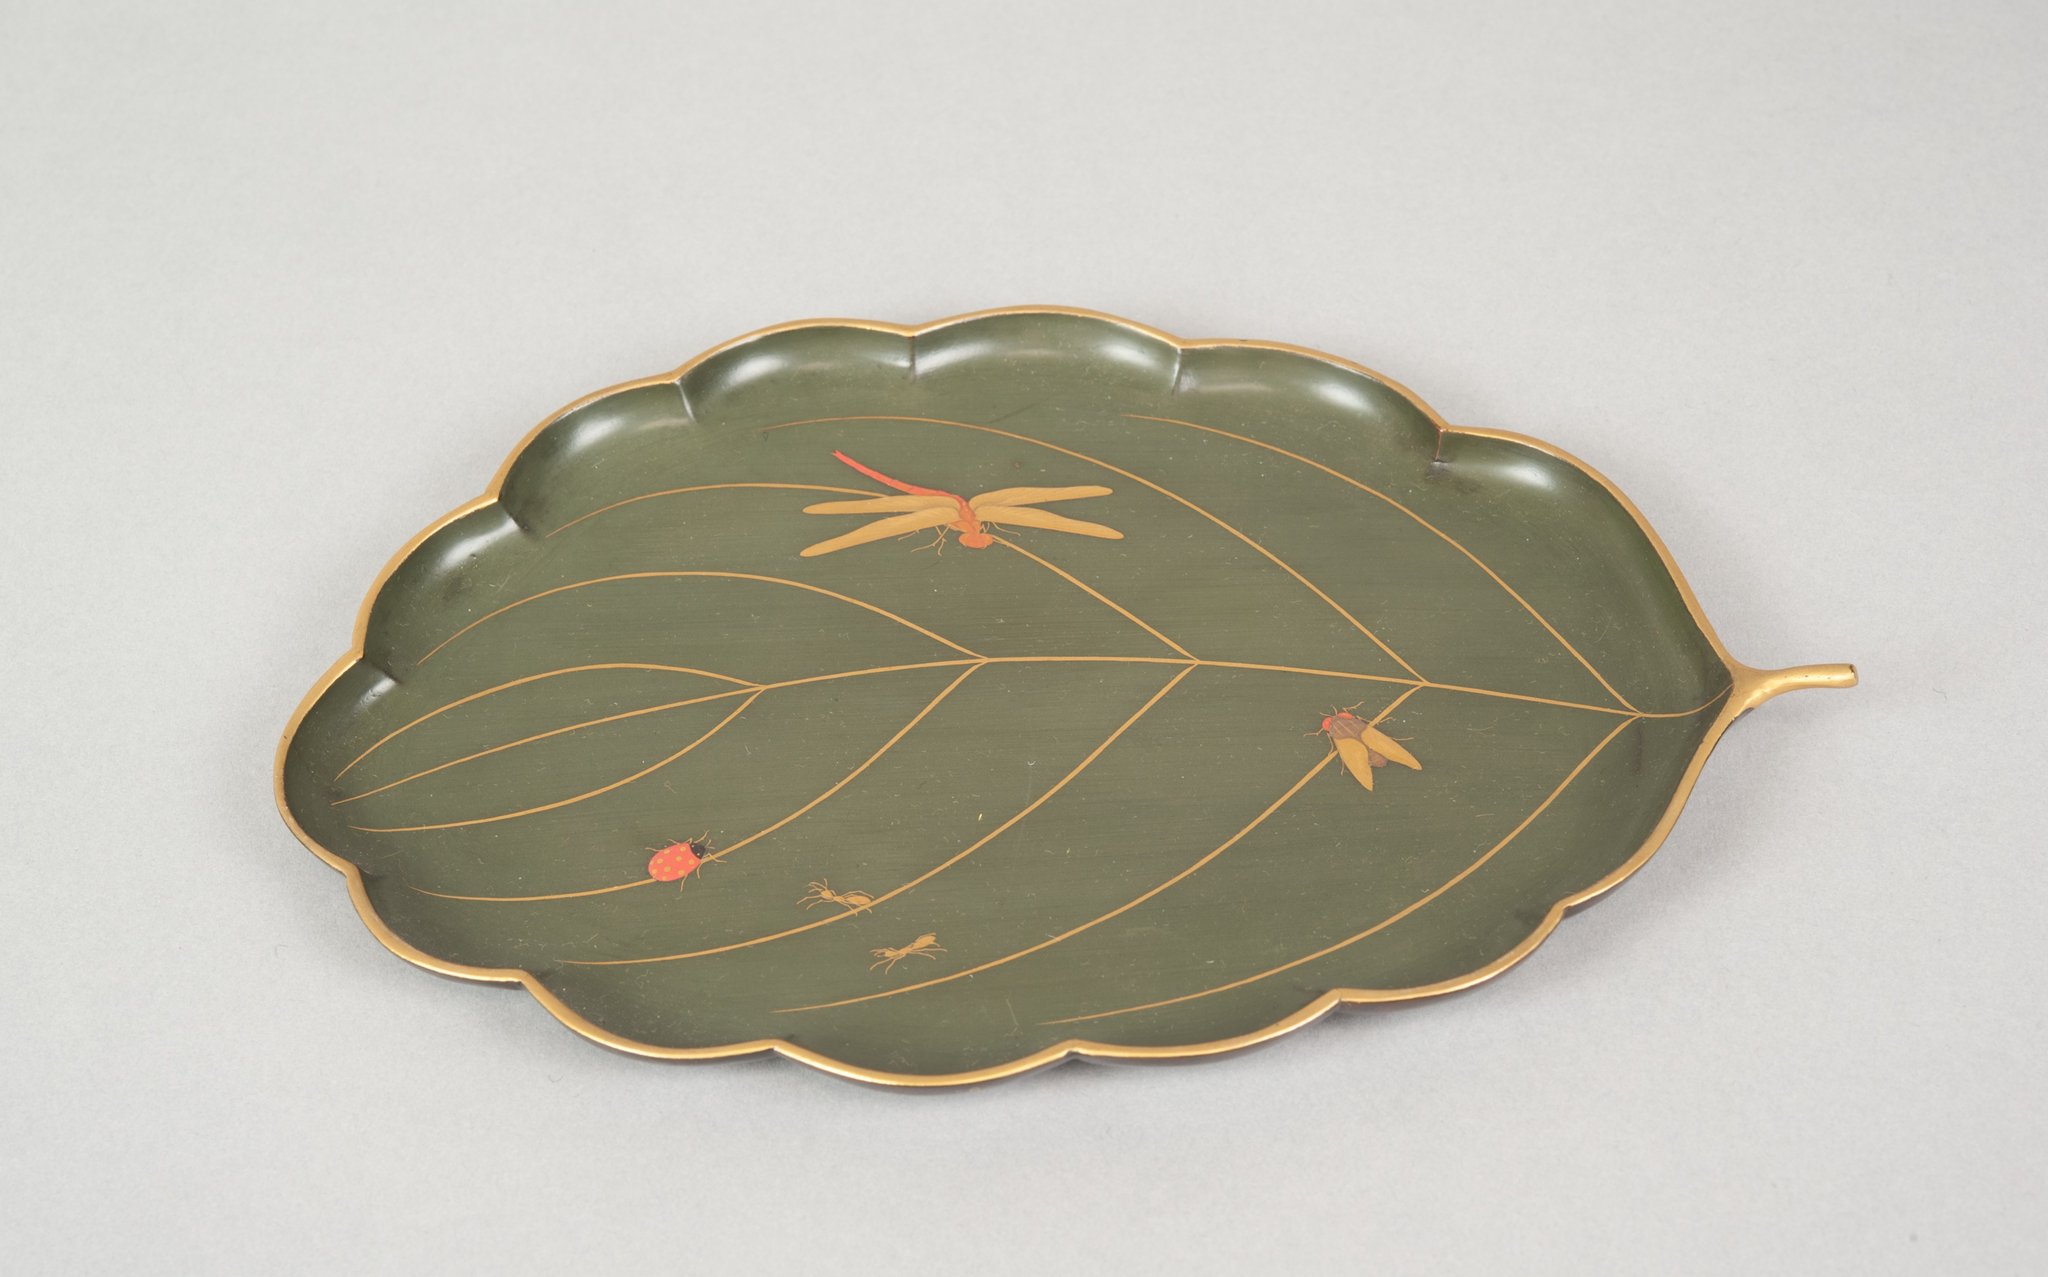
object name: tray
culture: japanese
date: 1801-1900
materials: lacquer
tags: insects,dragonflies